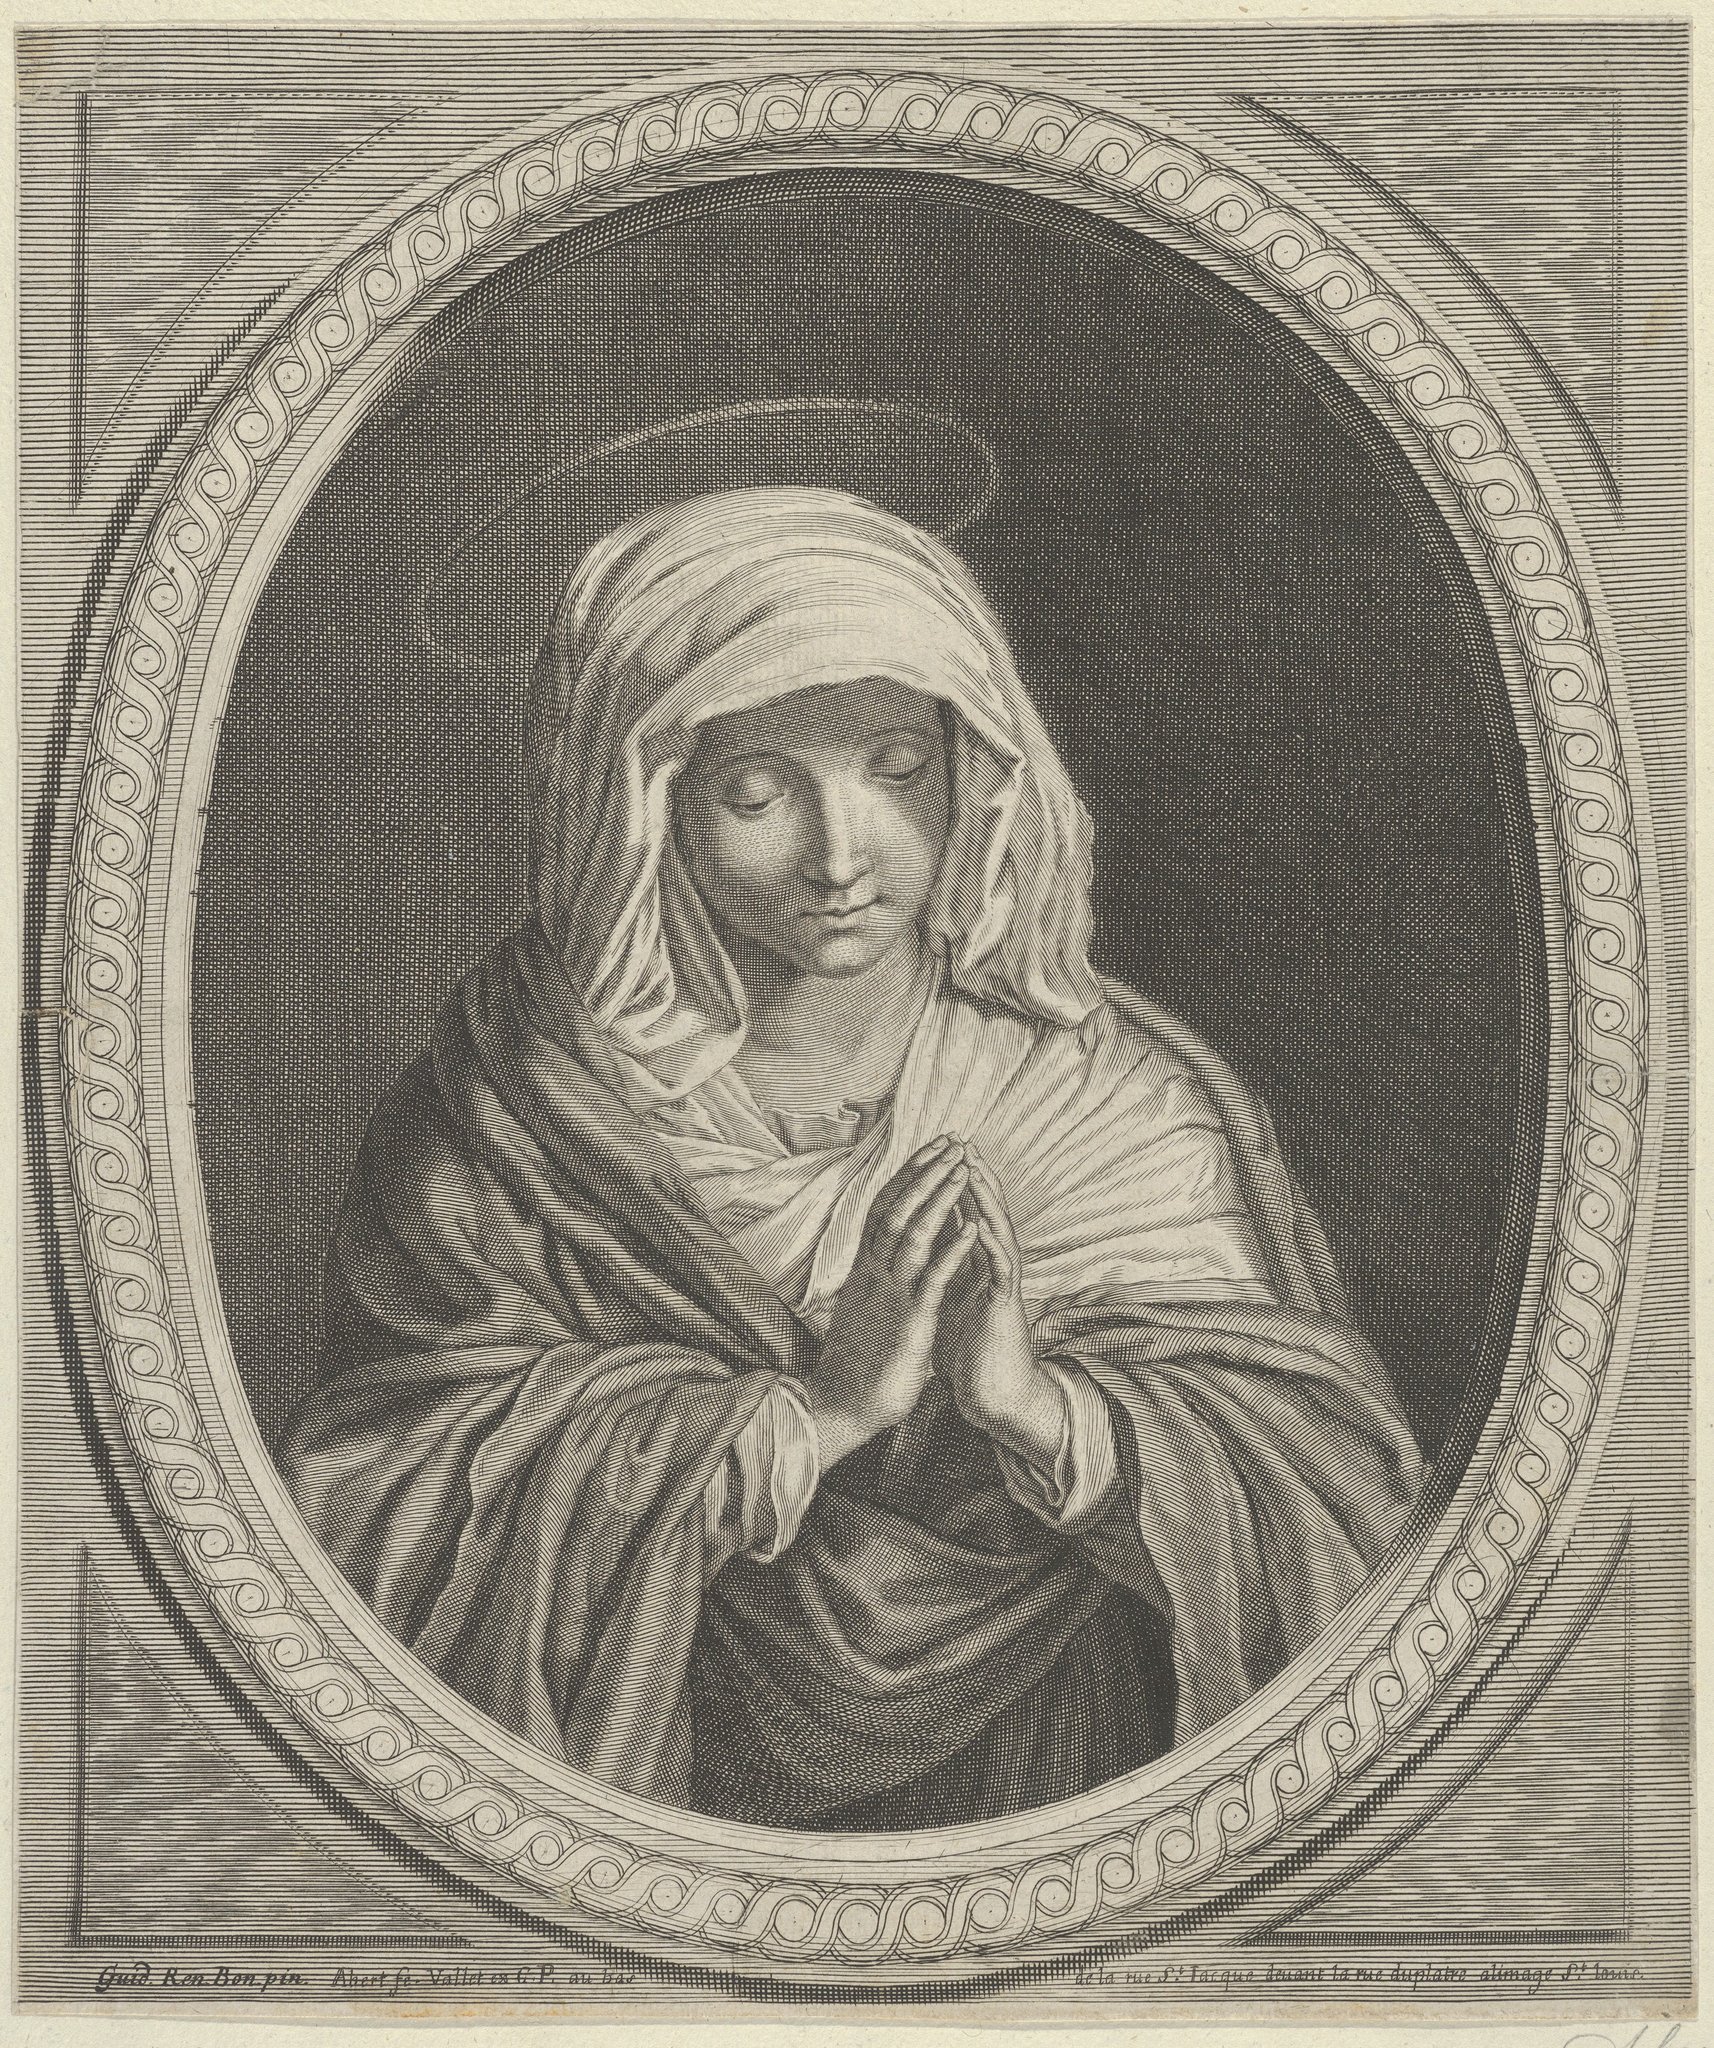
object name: print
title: The Virgin in prayer in an oval frame, after Reni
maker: Anonymous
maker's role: artist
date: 1650-1704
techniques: engraving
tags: portraits,virgin mary,praying